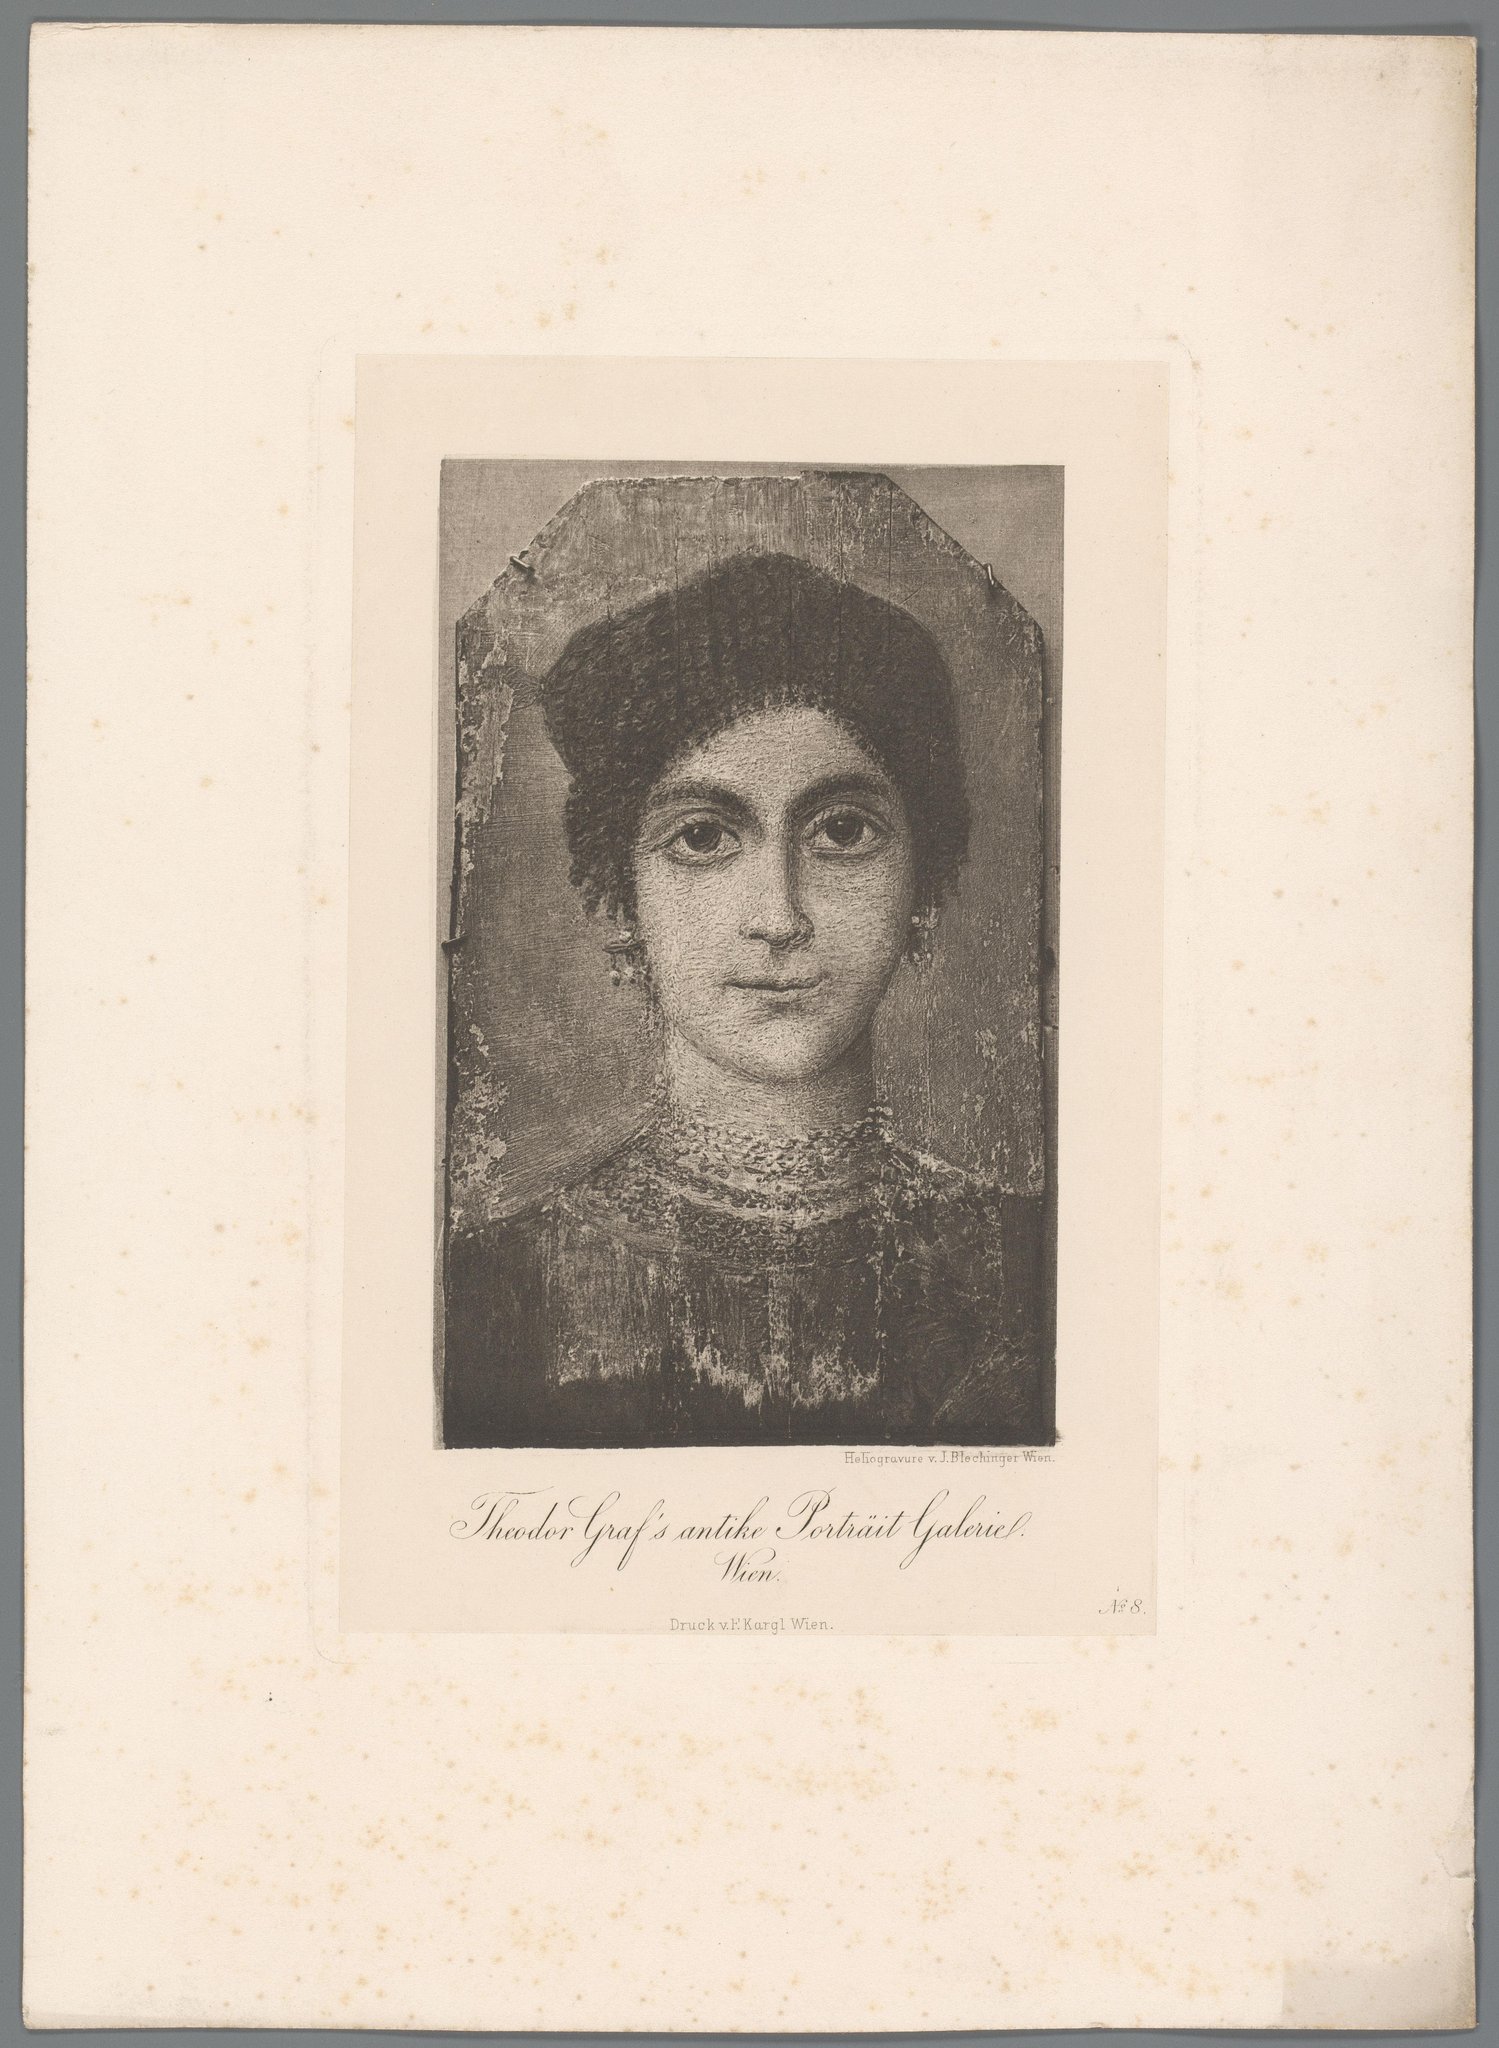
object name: reproduction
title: Fotoreproductie van een geschilderd portret van een onbekende Romeinse vrouw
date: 1860-1890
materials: paper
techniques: photoaquatint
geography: vienna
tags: historical persons not known by name - bb - woman, picture, painting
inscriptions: number: ‘No. 8’